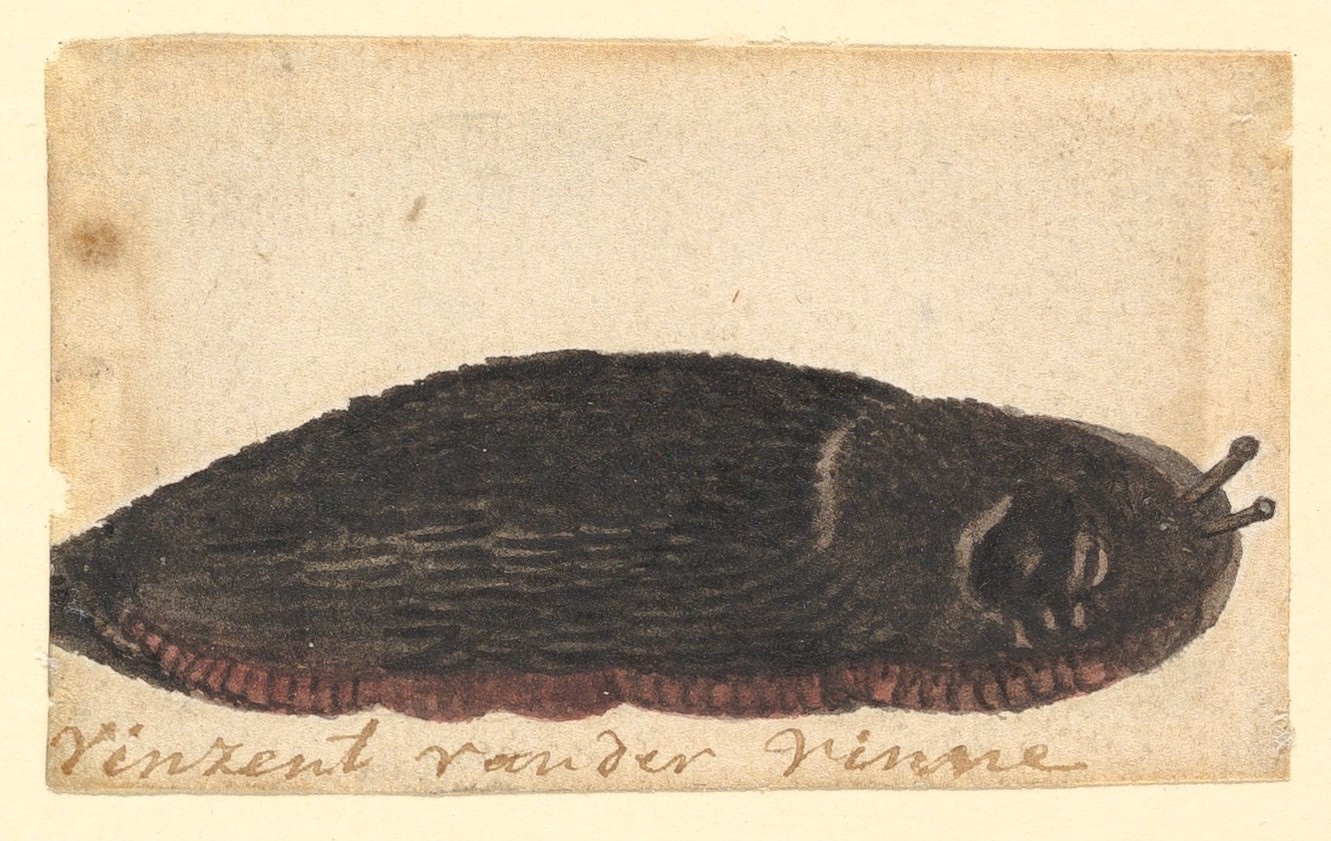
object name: drawing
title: A Slug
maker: vincent laurensz van der vinne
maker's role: artist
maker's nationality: dutch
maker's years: 1628-1702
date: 1667-1700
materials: watercolor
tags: insects